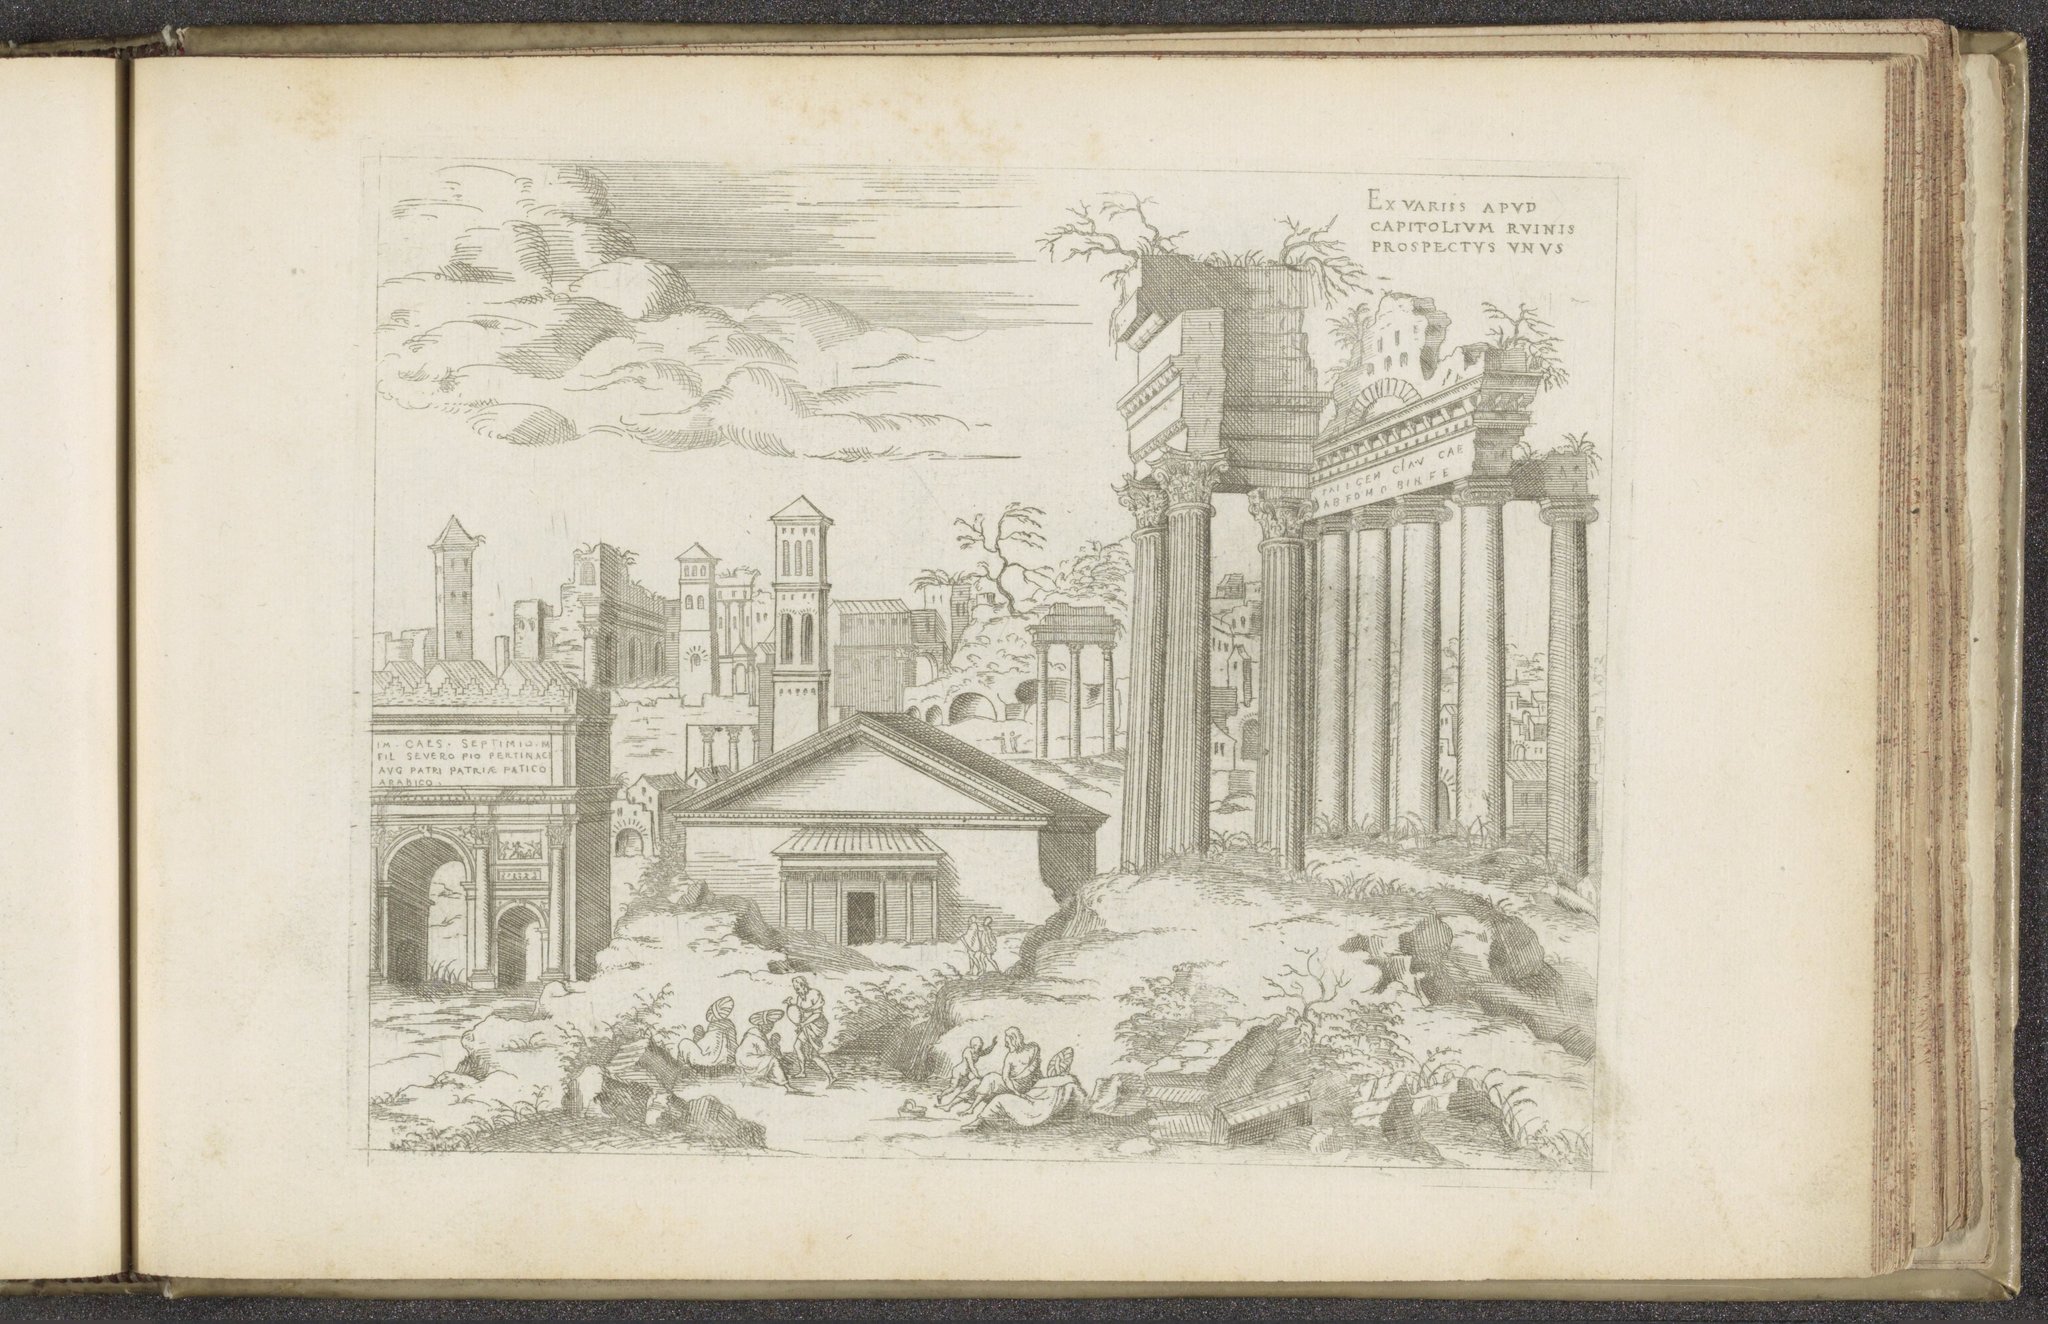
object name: album leaf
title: Ex Variis Apud Capitolium Ruinis Prospectus Unus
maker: jacques androuet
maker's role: draughtsman, print maker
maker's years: 1515-1584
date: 1551-1584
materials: paper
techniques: etching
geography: france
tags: ruin of a building ~ architecture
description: Gezicht op de ruïnes van het Forum Romanum vanuit het Capitool gezien. Tussen de ruïnes zitten mensen te eten en te rusten. Deze prent maakt deel uit van een album.